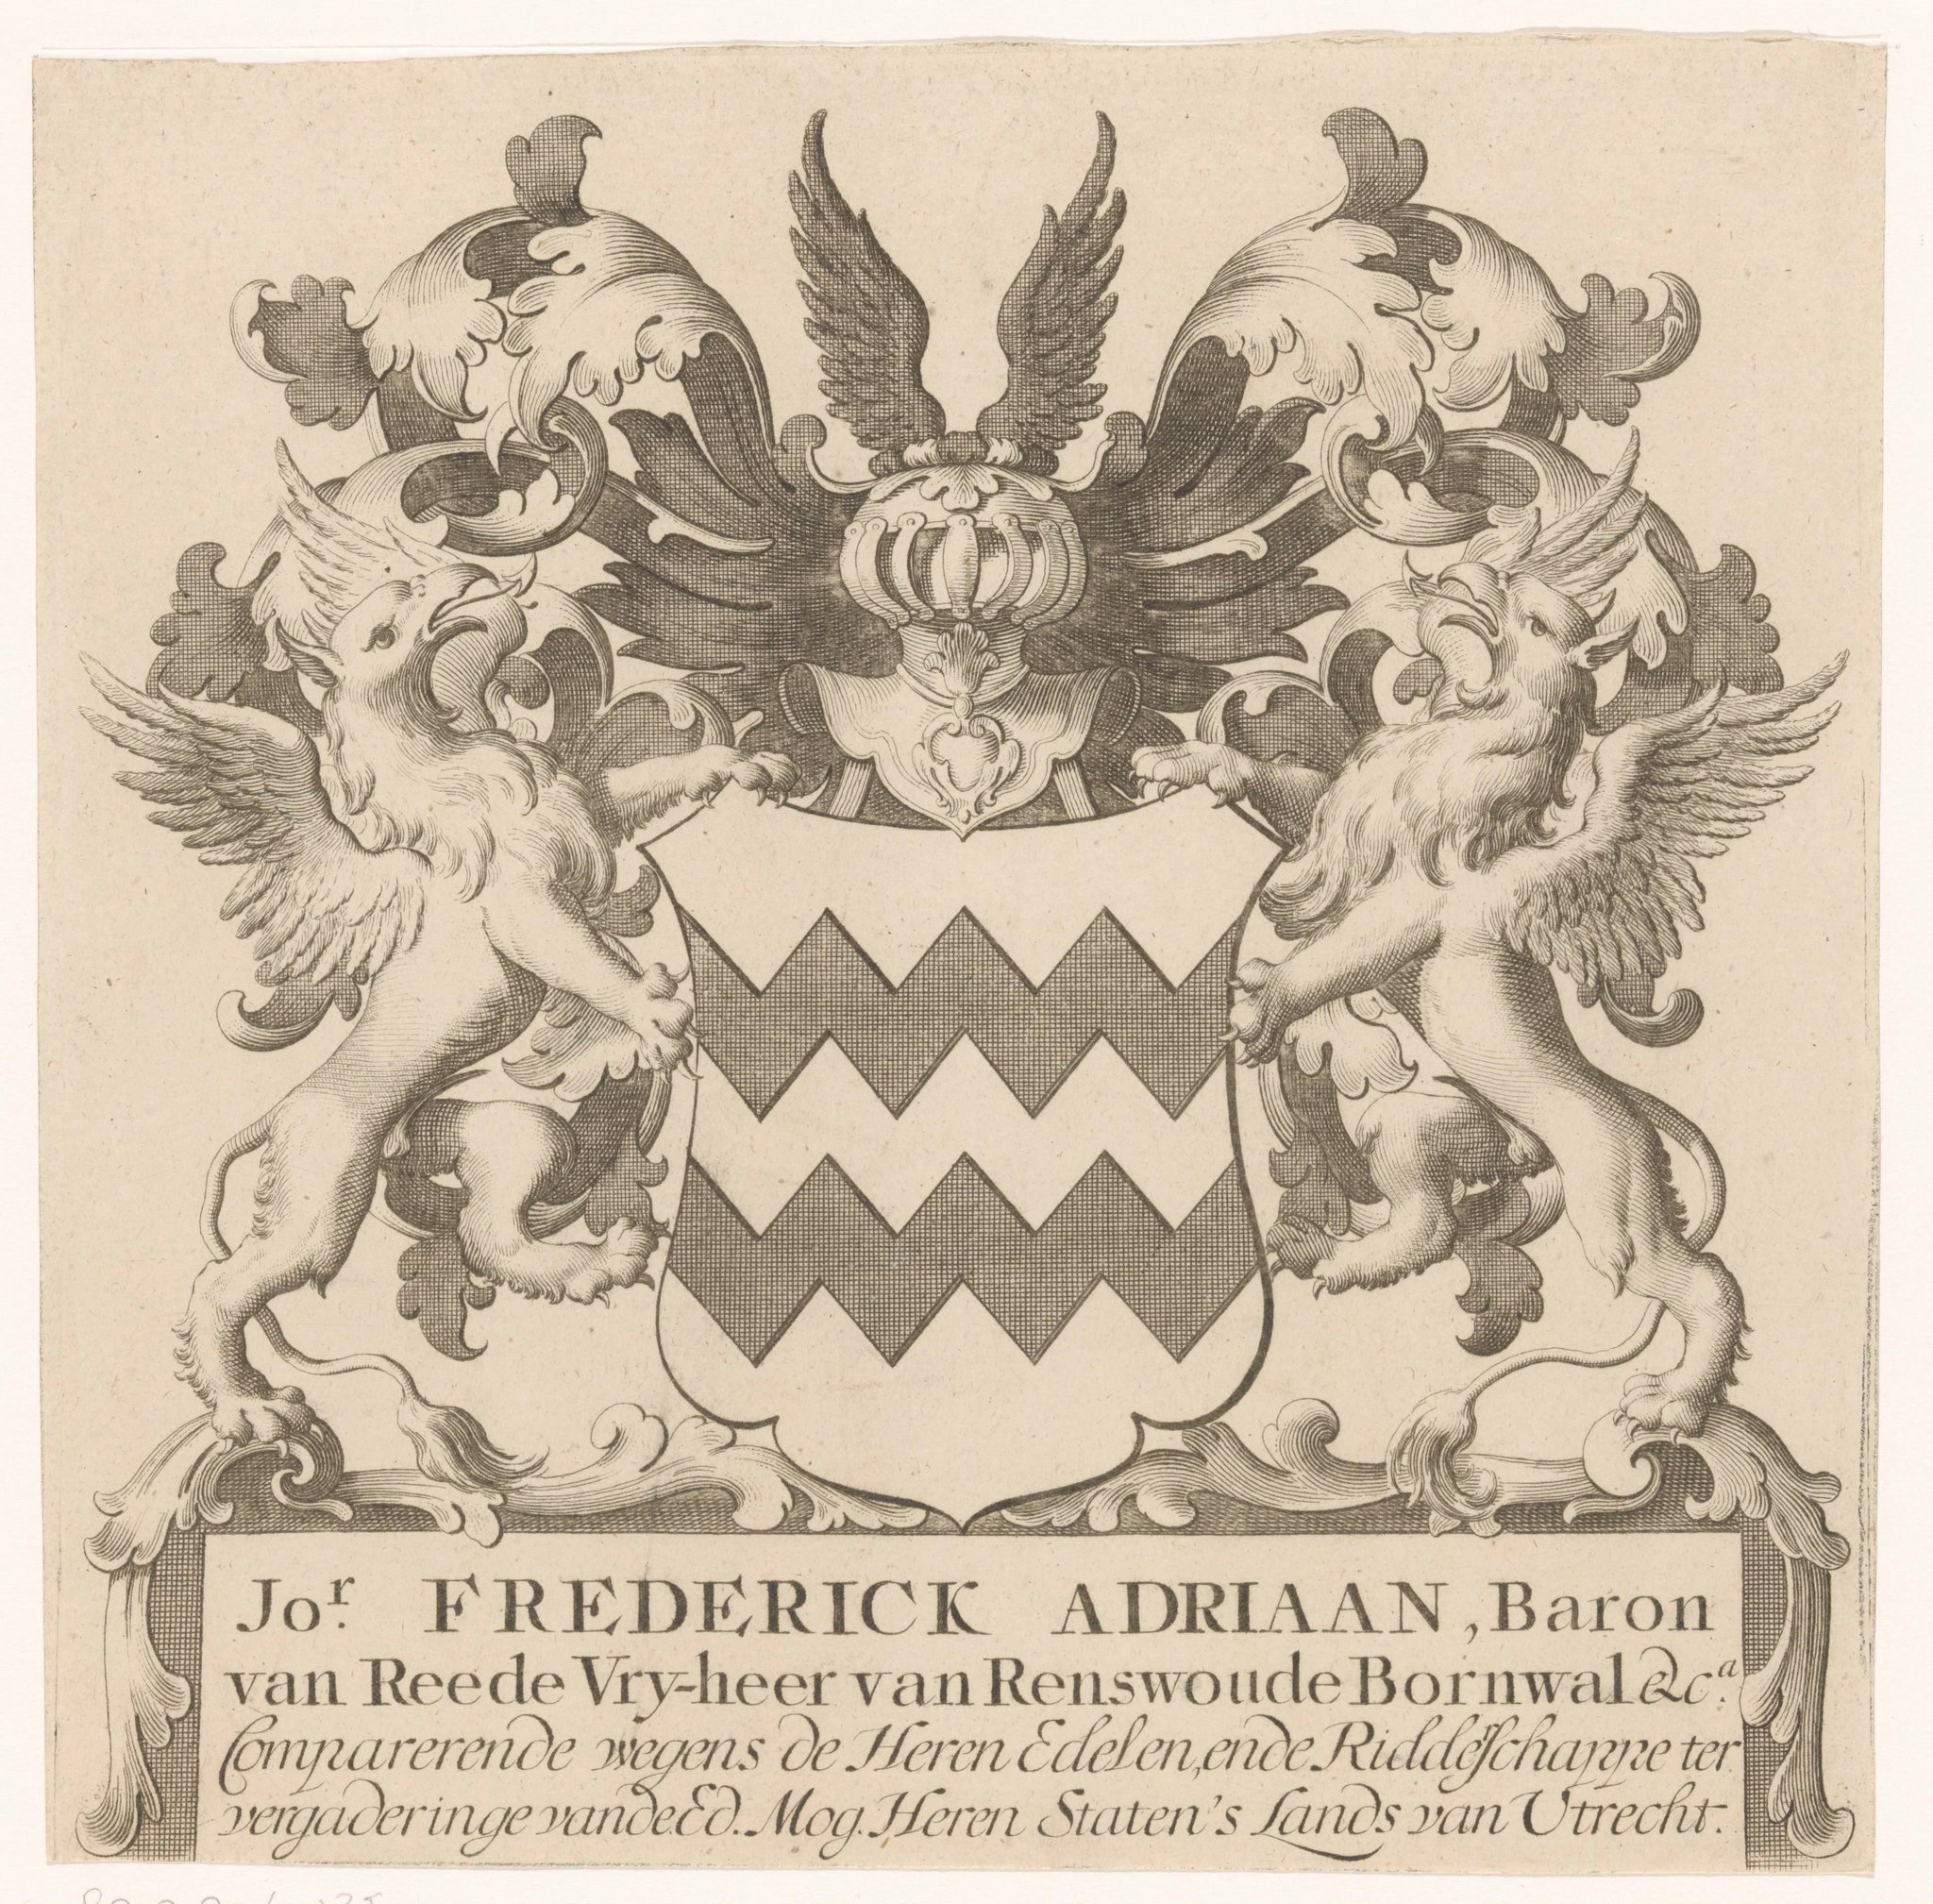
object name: print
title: Wapenschild van Frederik Adriaan van Reede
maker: Anonymous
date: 1659-1738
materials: paper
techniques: etching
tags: utrecht, armorial bearing, heraldry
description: Wapenschild van Frederik Adriaan van Reede met griffioenen als schildhouders en een helmteken met vleugels. Aan de onderzijde een vierregelige Nederlandse tekst met zijn naam en titel.